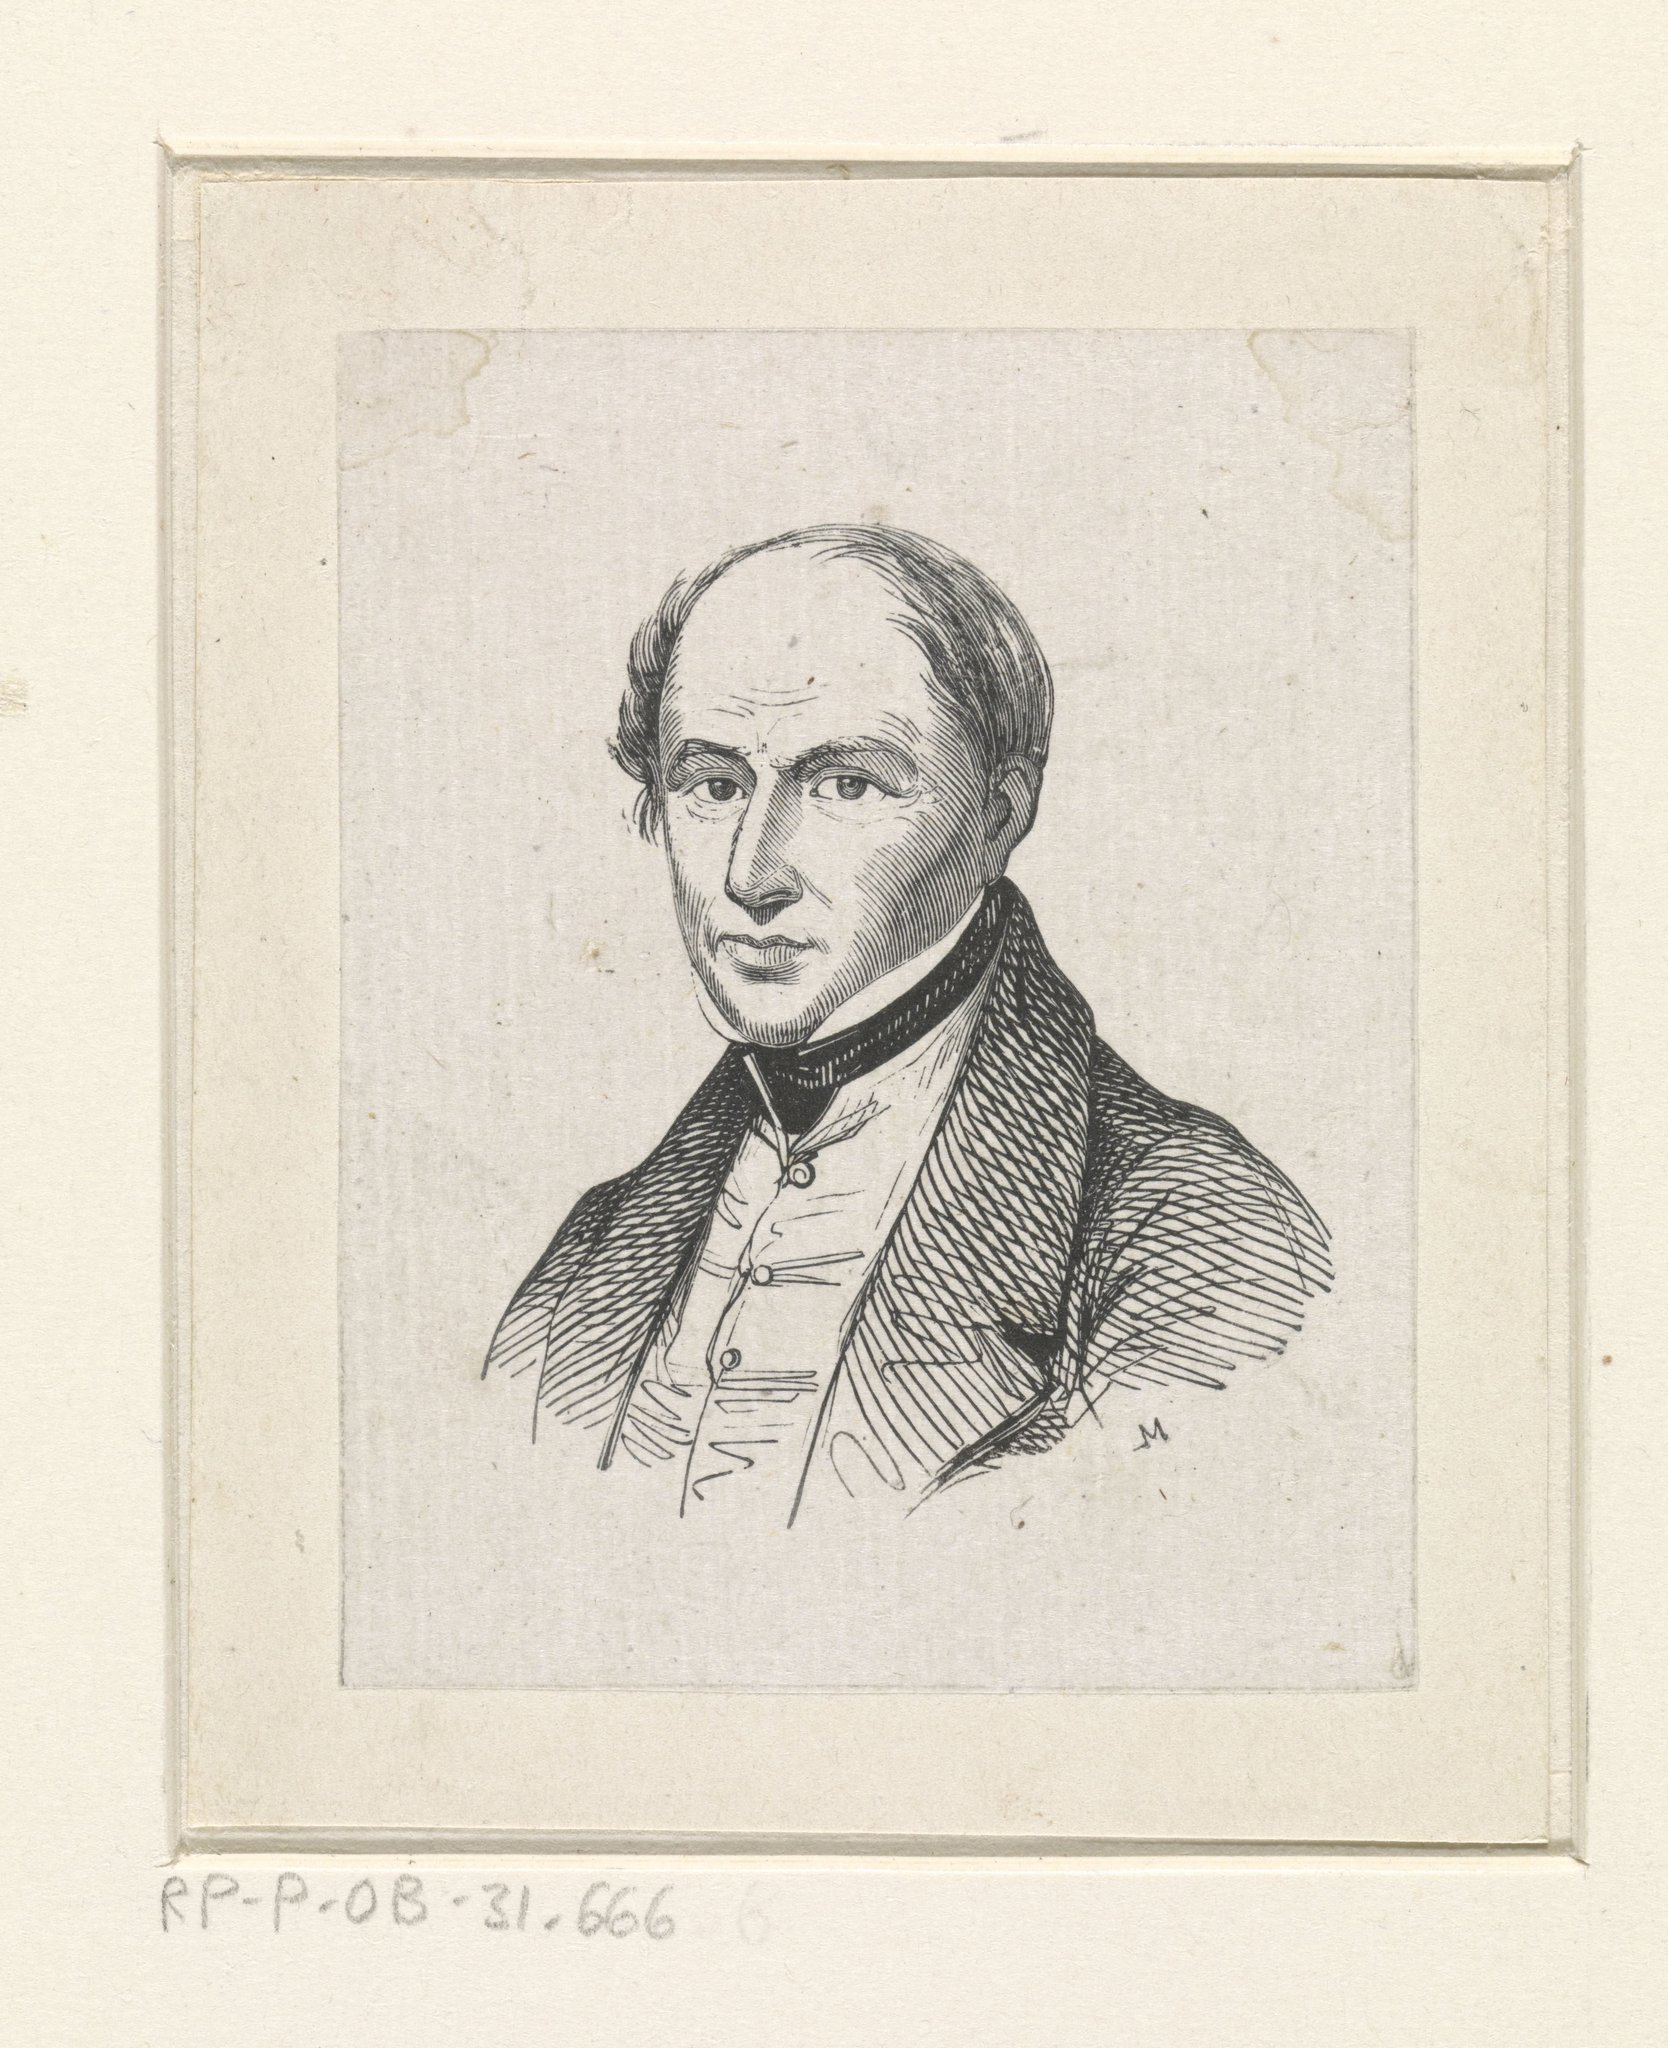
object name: print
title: Portret van Albertus Brondgeest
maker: monogrammist m (duitsland)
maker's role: print maker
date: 1841-1842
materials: paper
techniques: engraving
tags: amsterdam, print maker, draughtsman, albertus brondgeest, historical persons, portrait, self-portrait of painter, portrait, self-portrait of artist, portrait, self-portrait of draughtsman